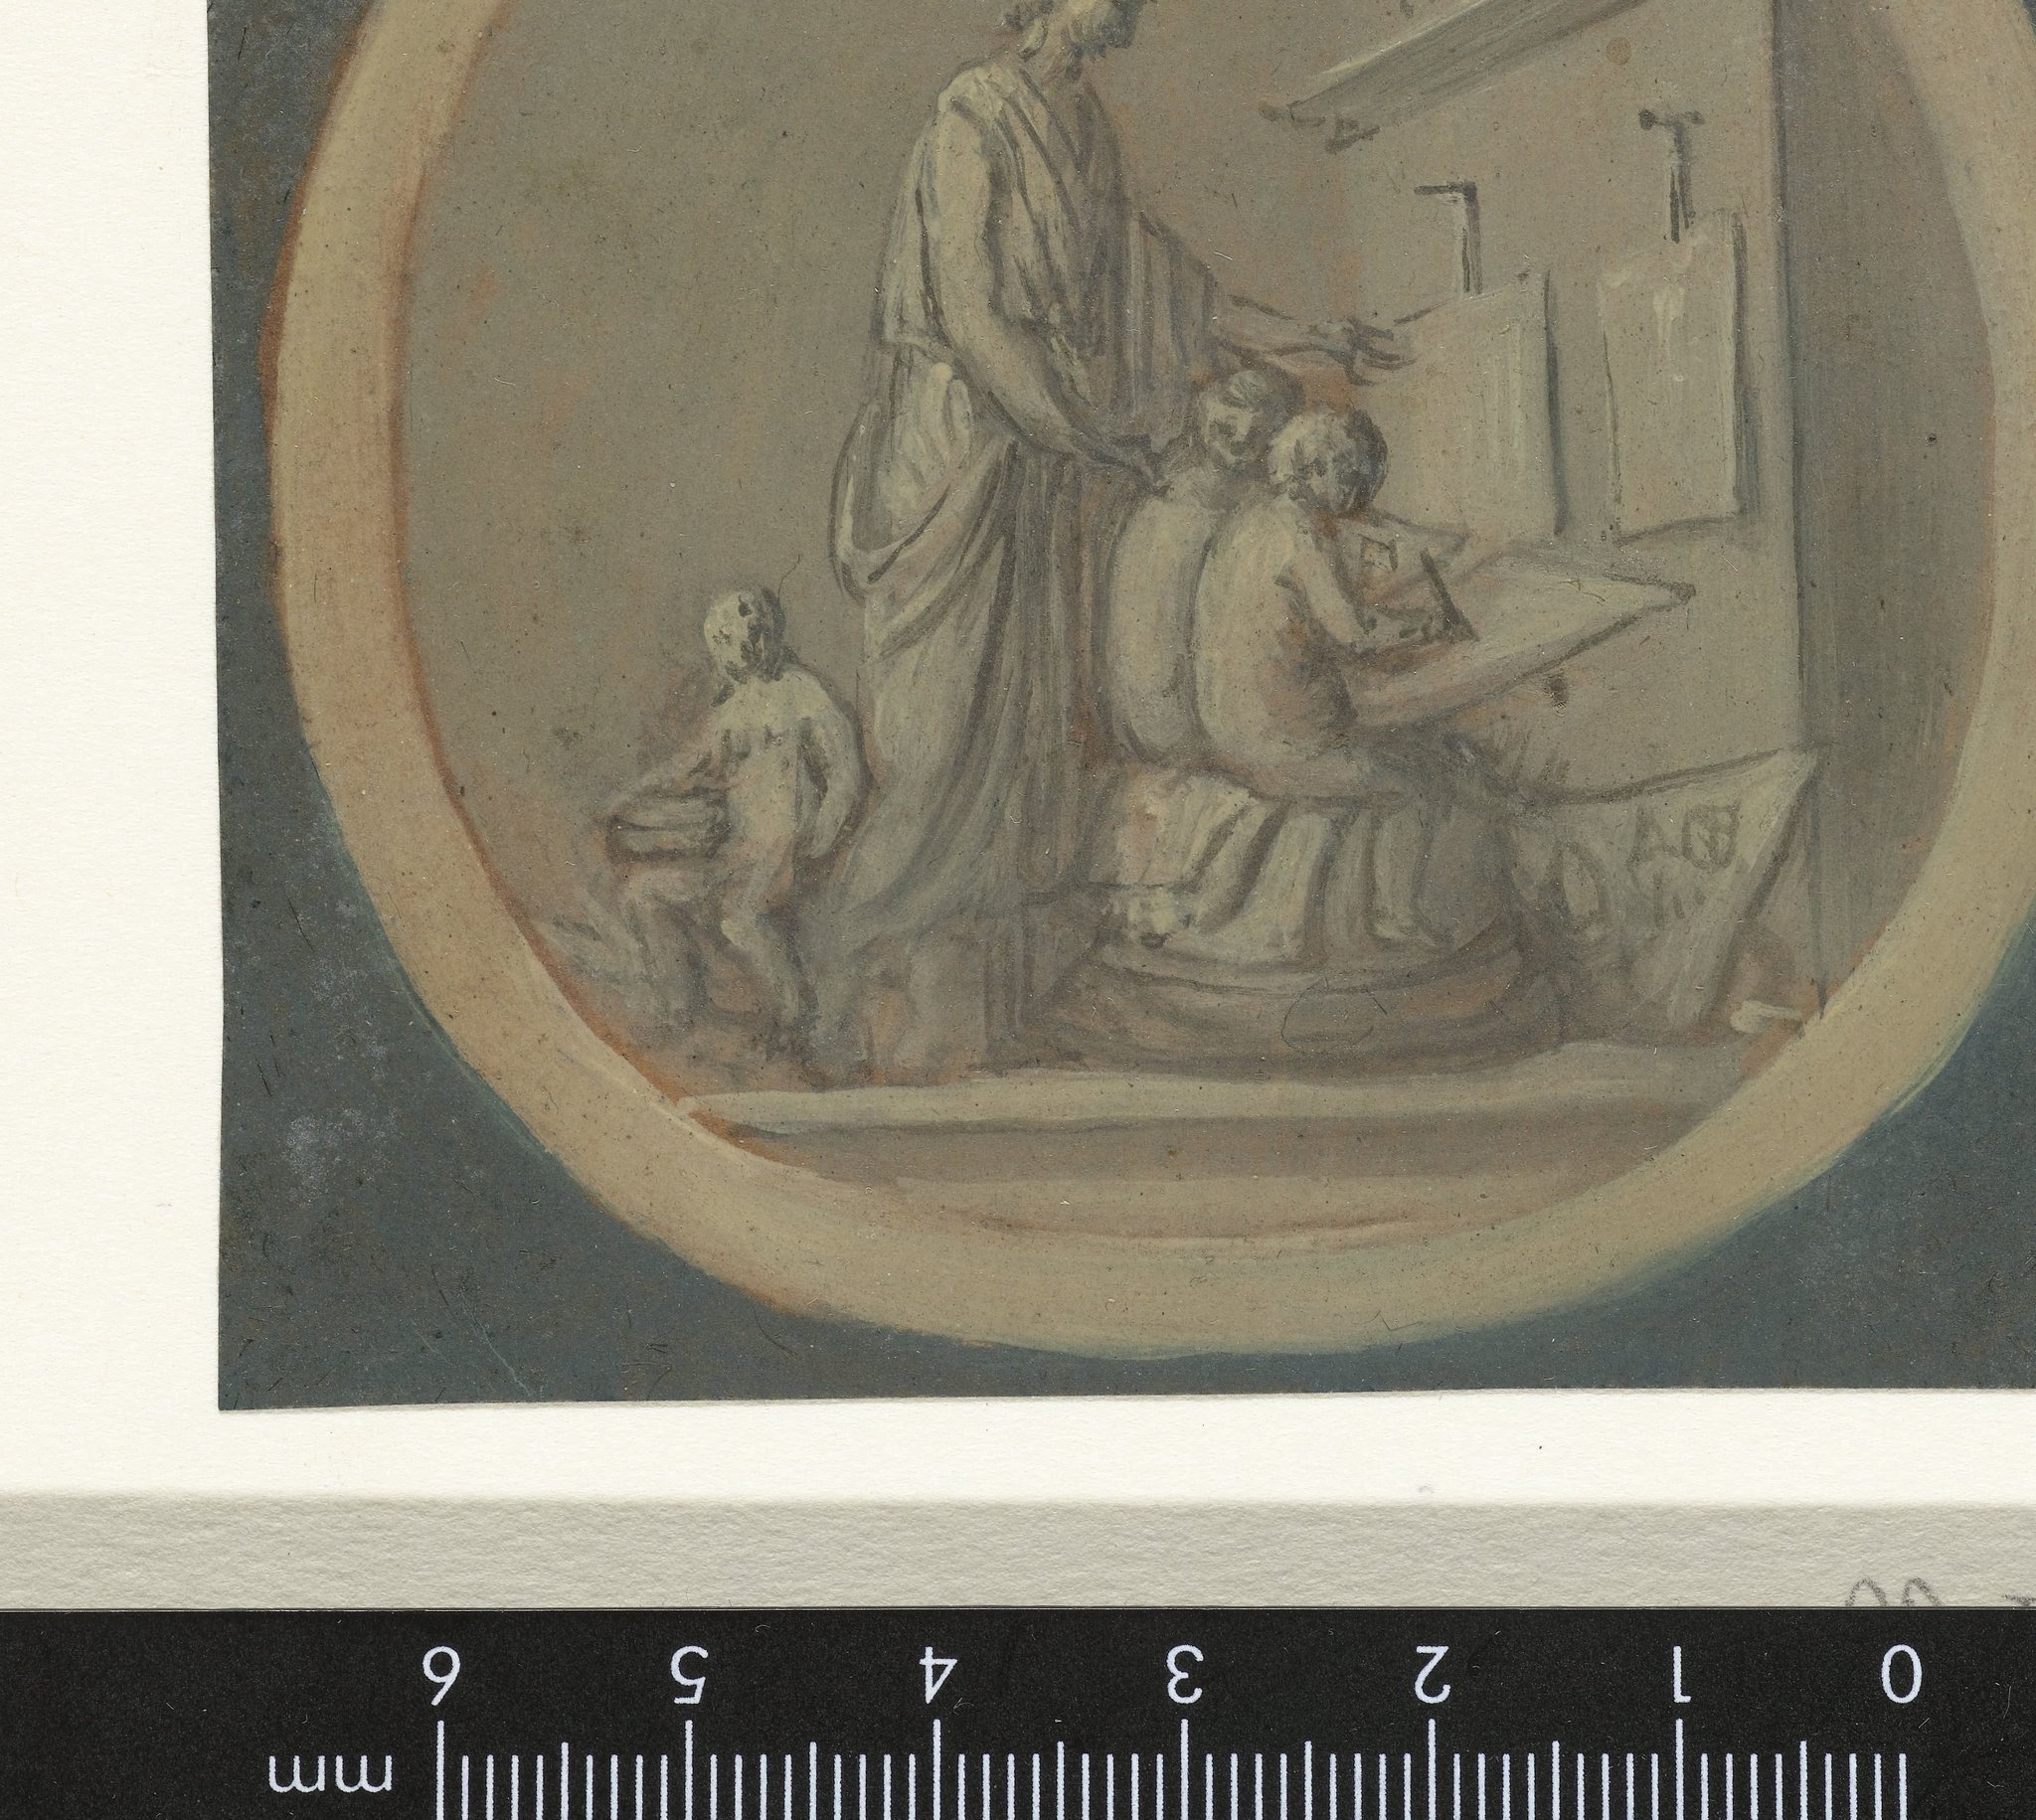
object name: drawing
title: Vignet met Minerva onderwijzend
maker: Anonymous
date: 1700-1800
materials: oil, paper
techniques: brush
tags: minerva as patroness, art